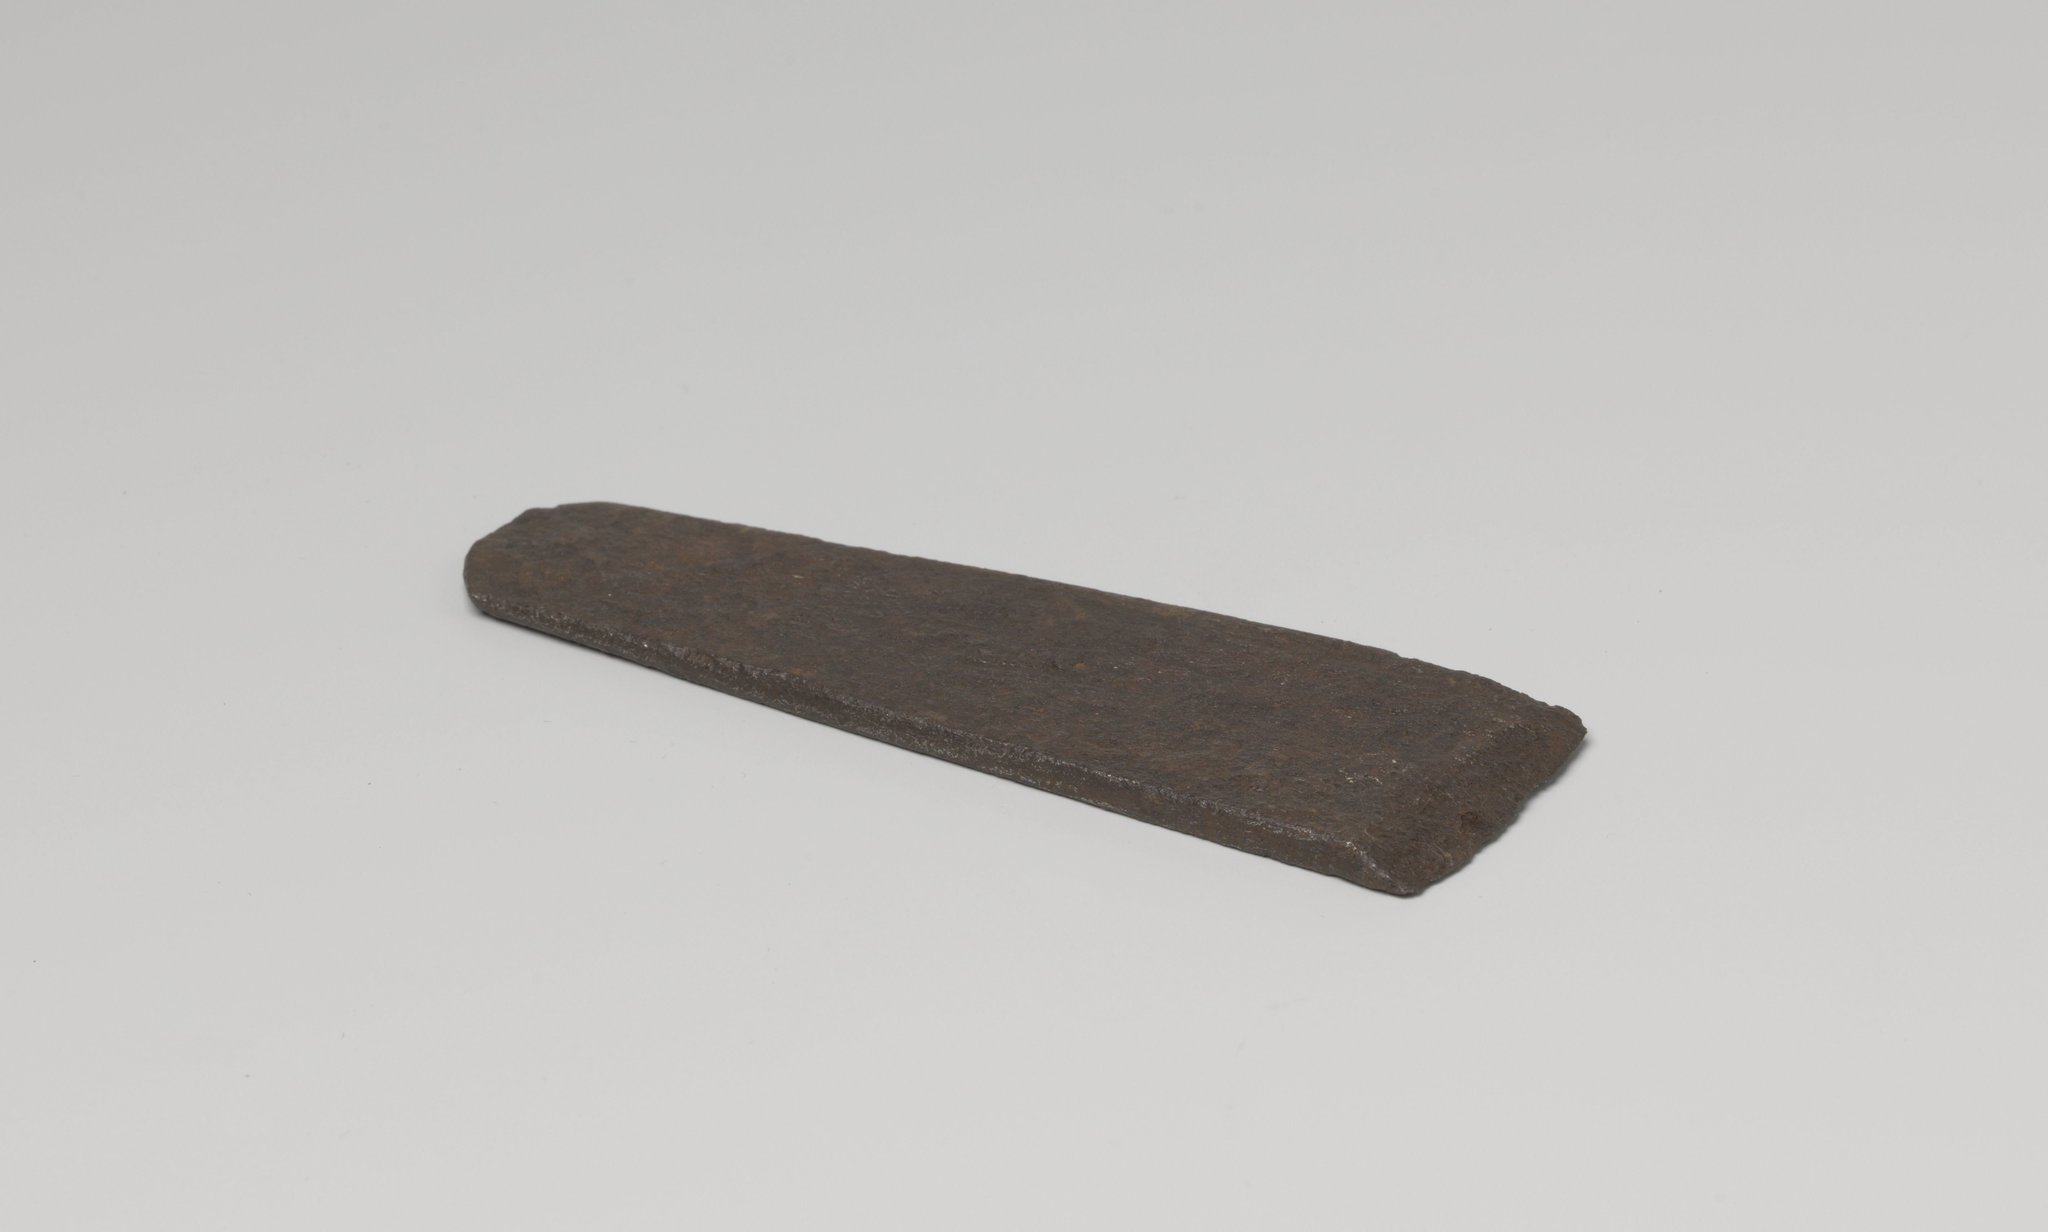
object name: schaafbeitel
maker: Anonymous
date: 1590-1596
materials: iron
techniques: forging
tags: willem barendsz., amsterdam, jacob van heemskerck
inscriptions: mark